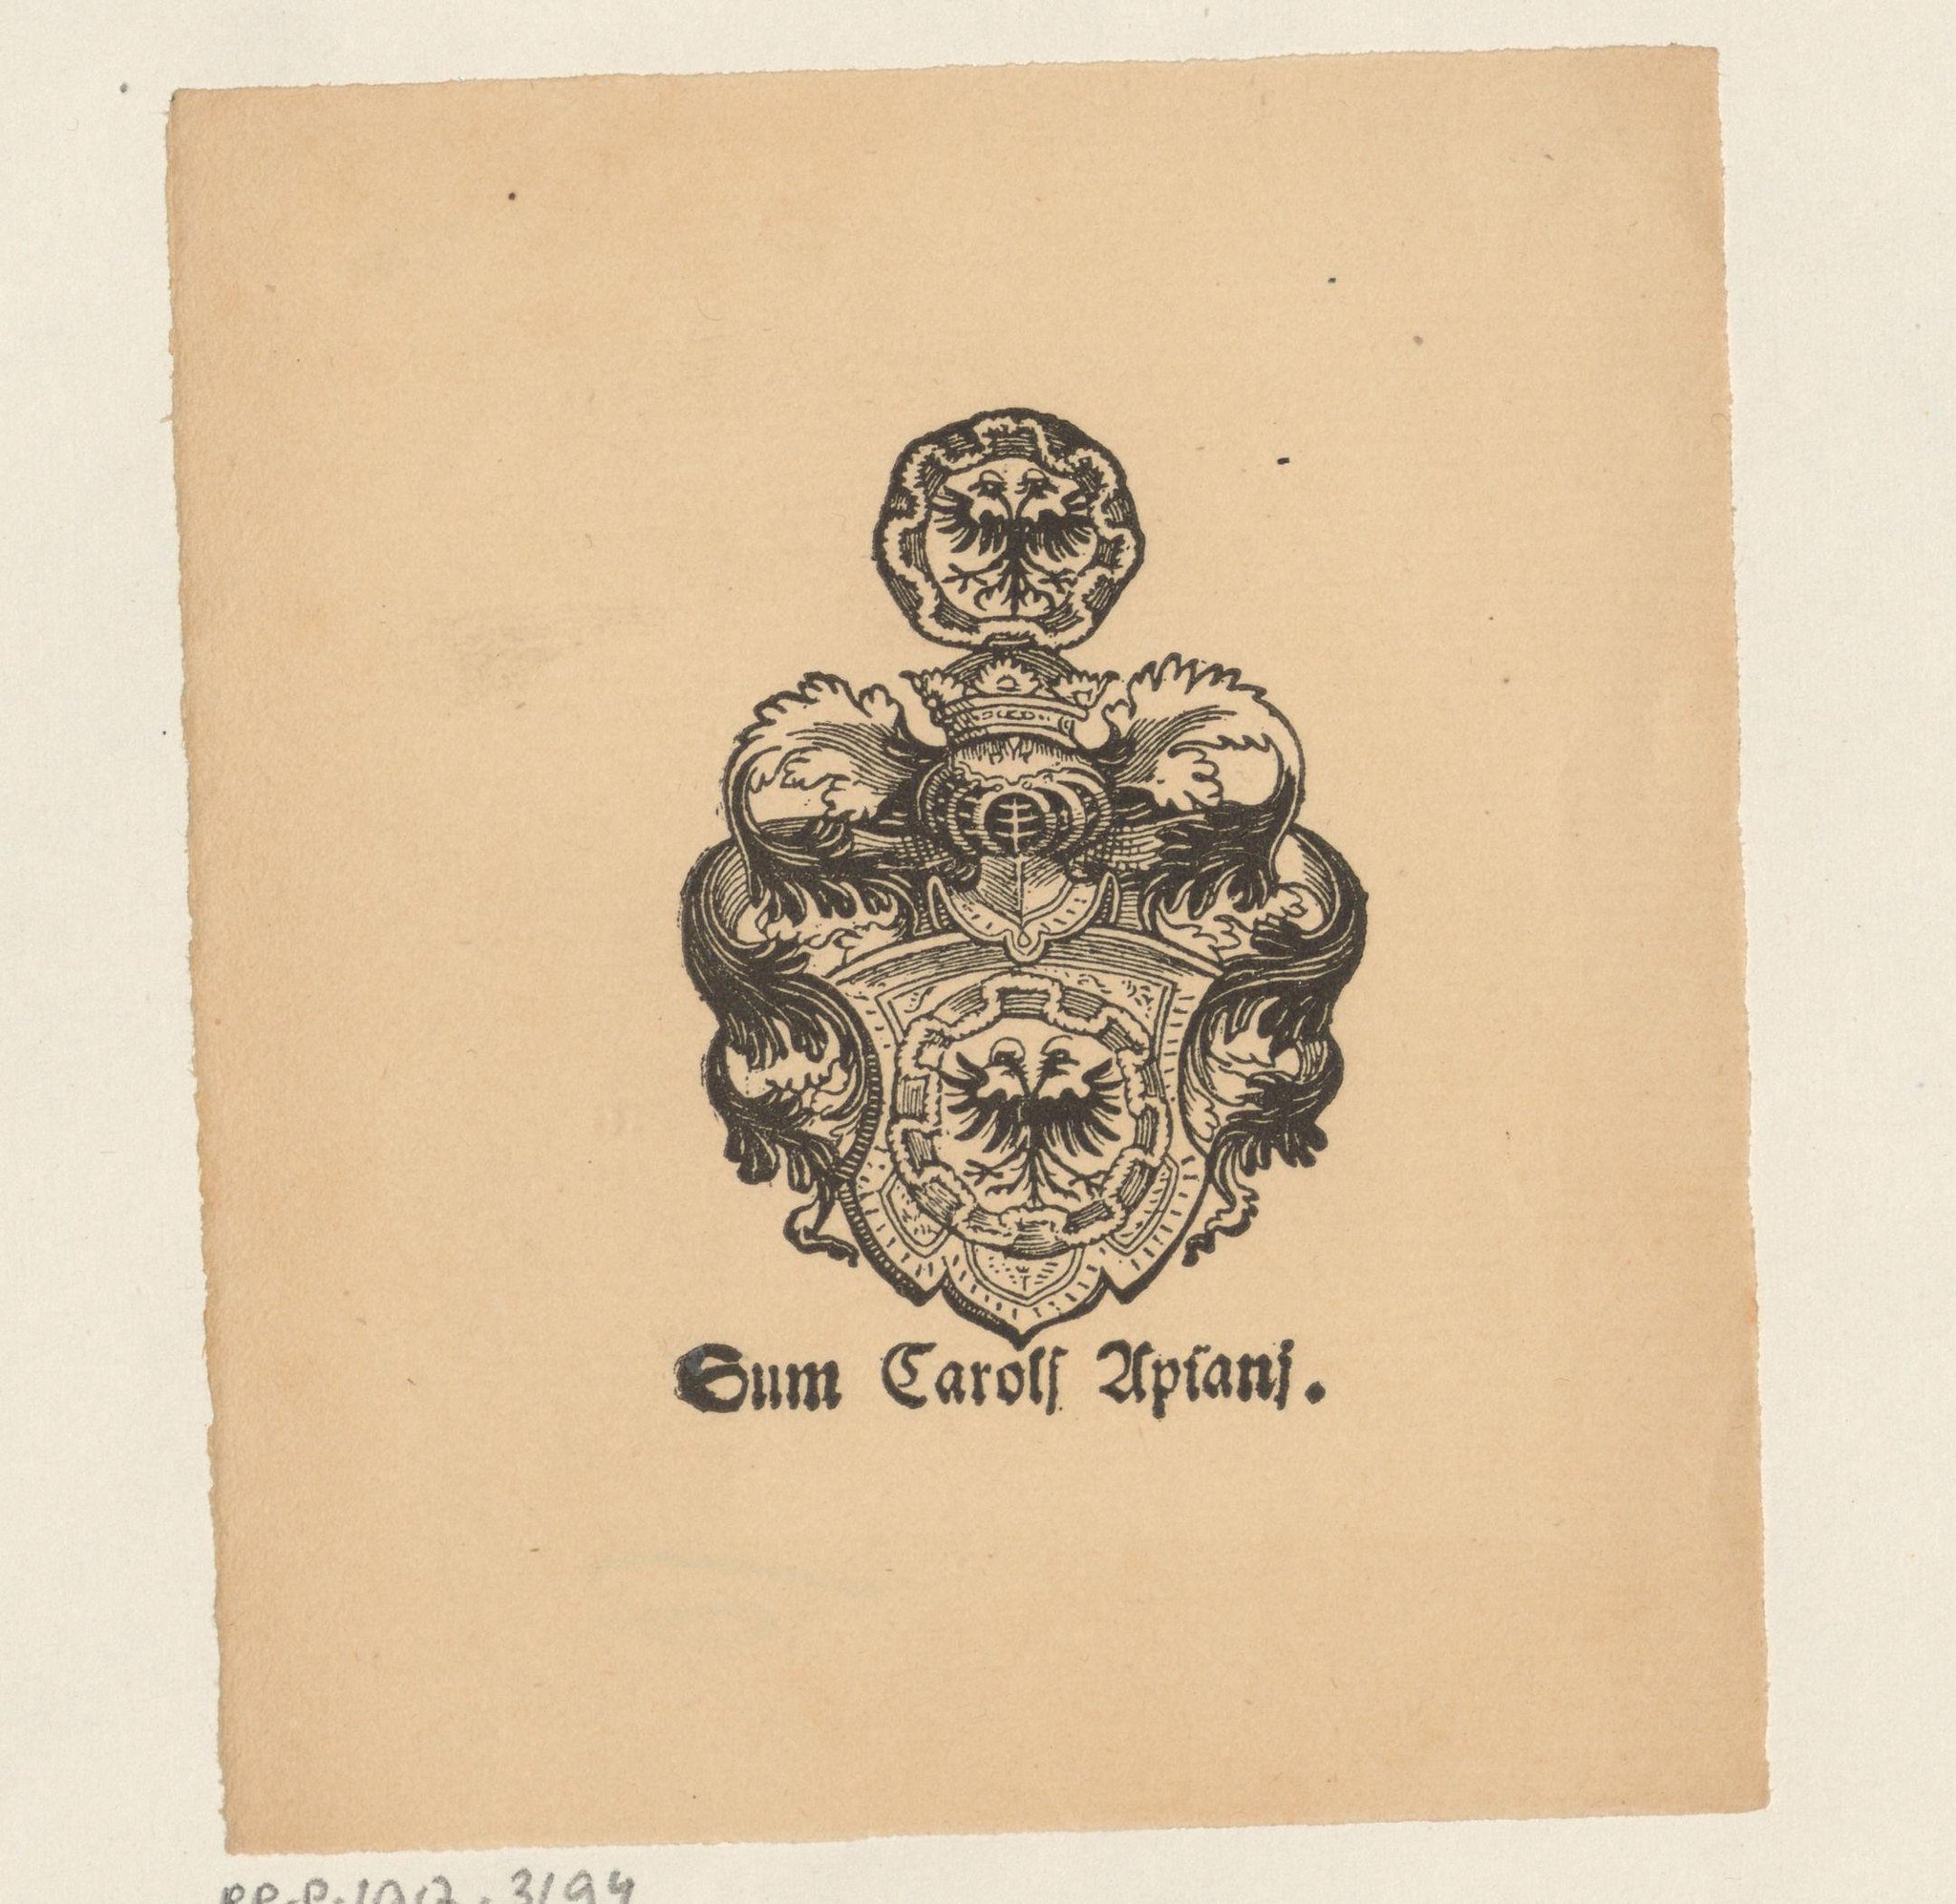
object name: bookplate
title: Ex libris van Carolus Upsanus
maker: Anonymous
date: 1850-1950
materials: paper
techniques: printing block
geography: germany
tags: double-headed eagle, armorial bearing, heraldry